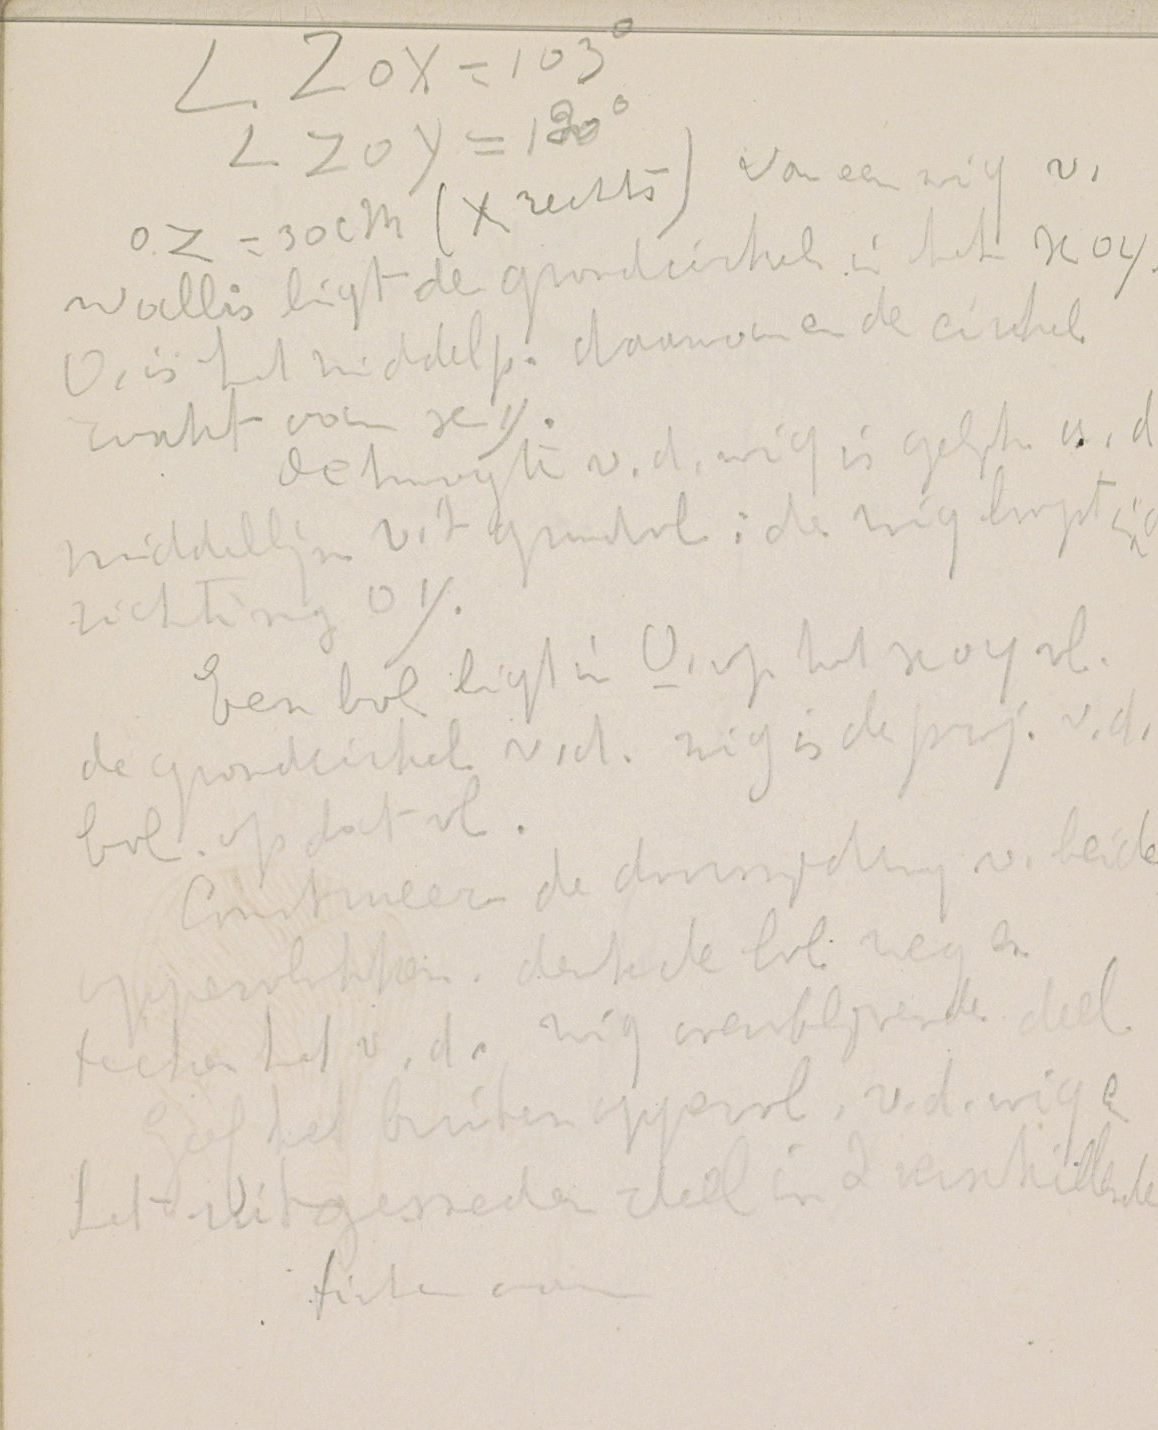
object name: sketchbook leaf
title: Notities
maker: reijer stolk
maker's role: draughtsman, print maker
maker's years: 1896-1945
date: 1916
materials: paper, pencil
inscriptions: annotation: ‘[...]’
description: Blad 24 verso uit een schetsboek met 72 bladen.